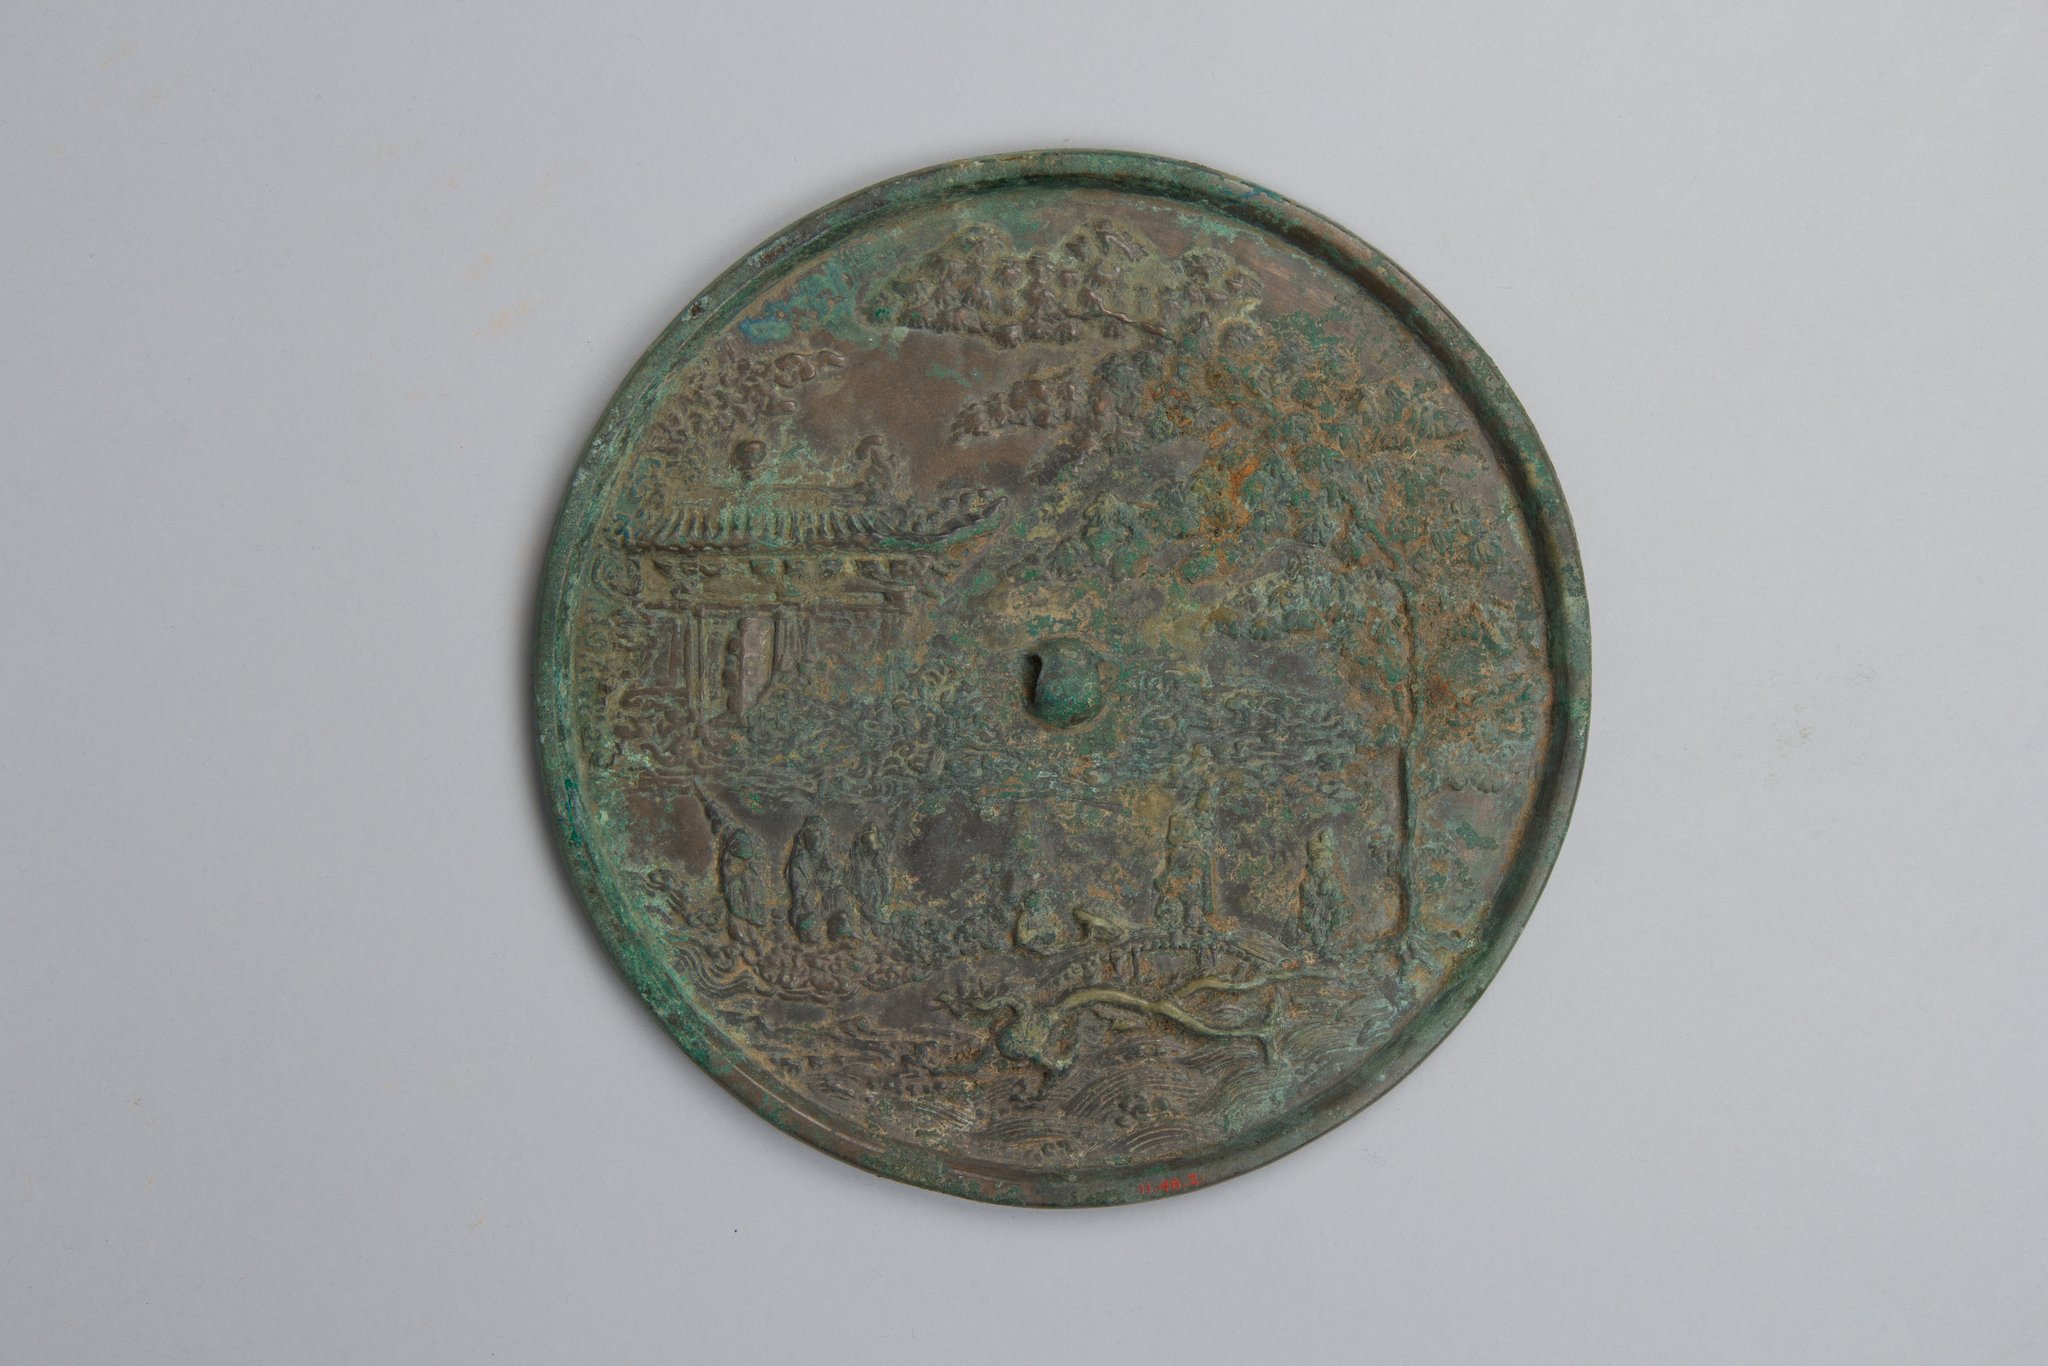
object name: mirror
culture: korean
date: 1101-1300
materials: bronze, silver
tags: trees